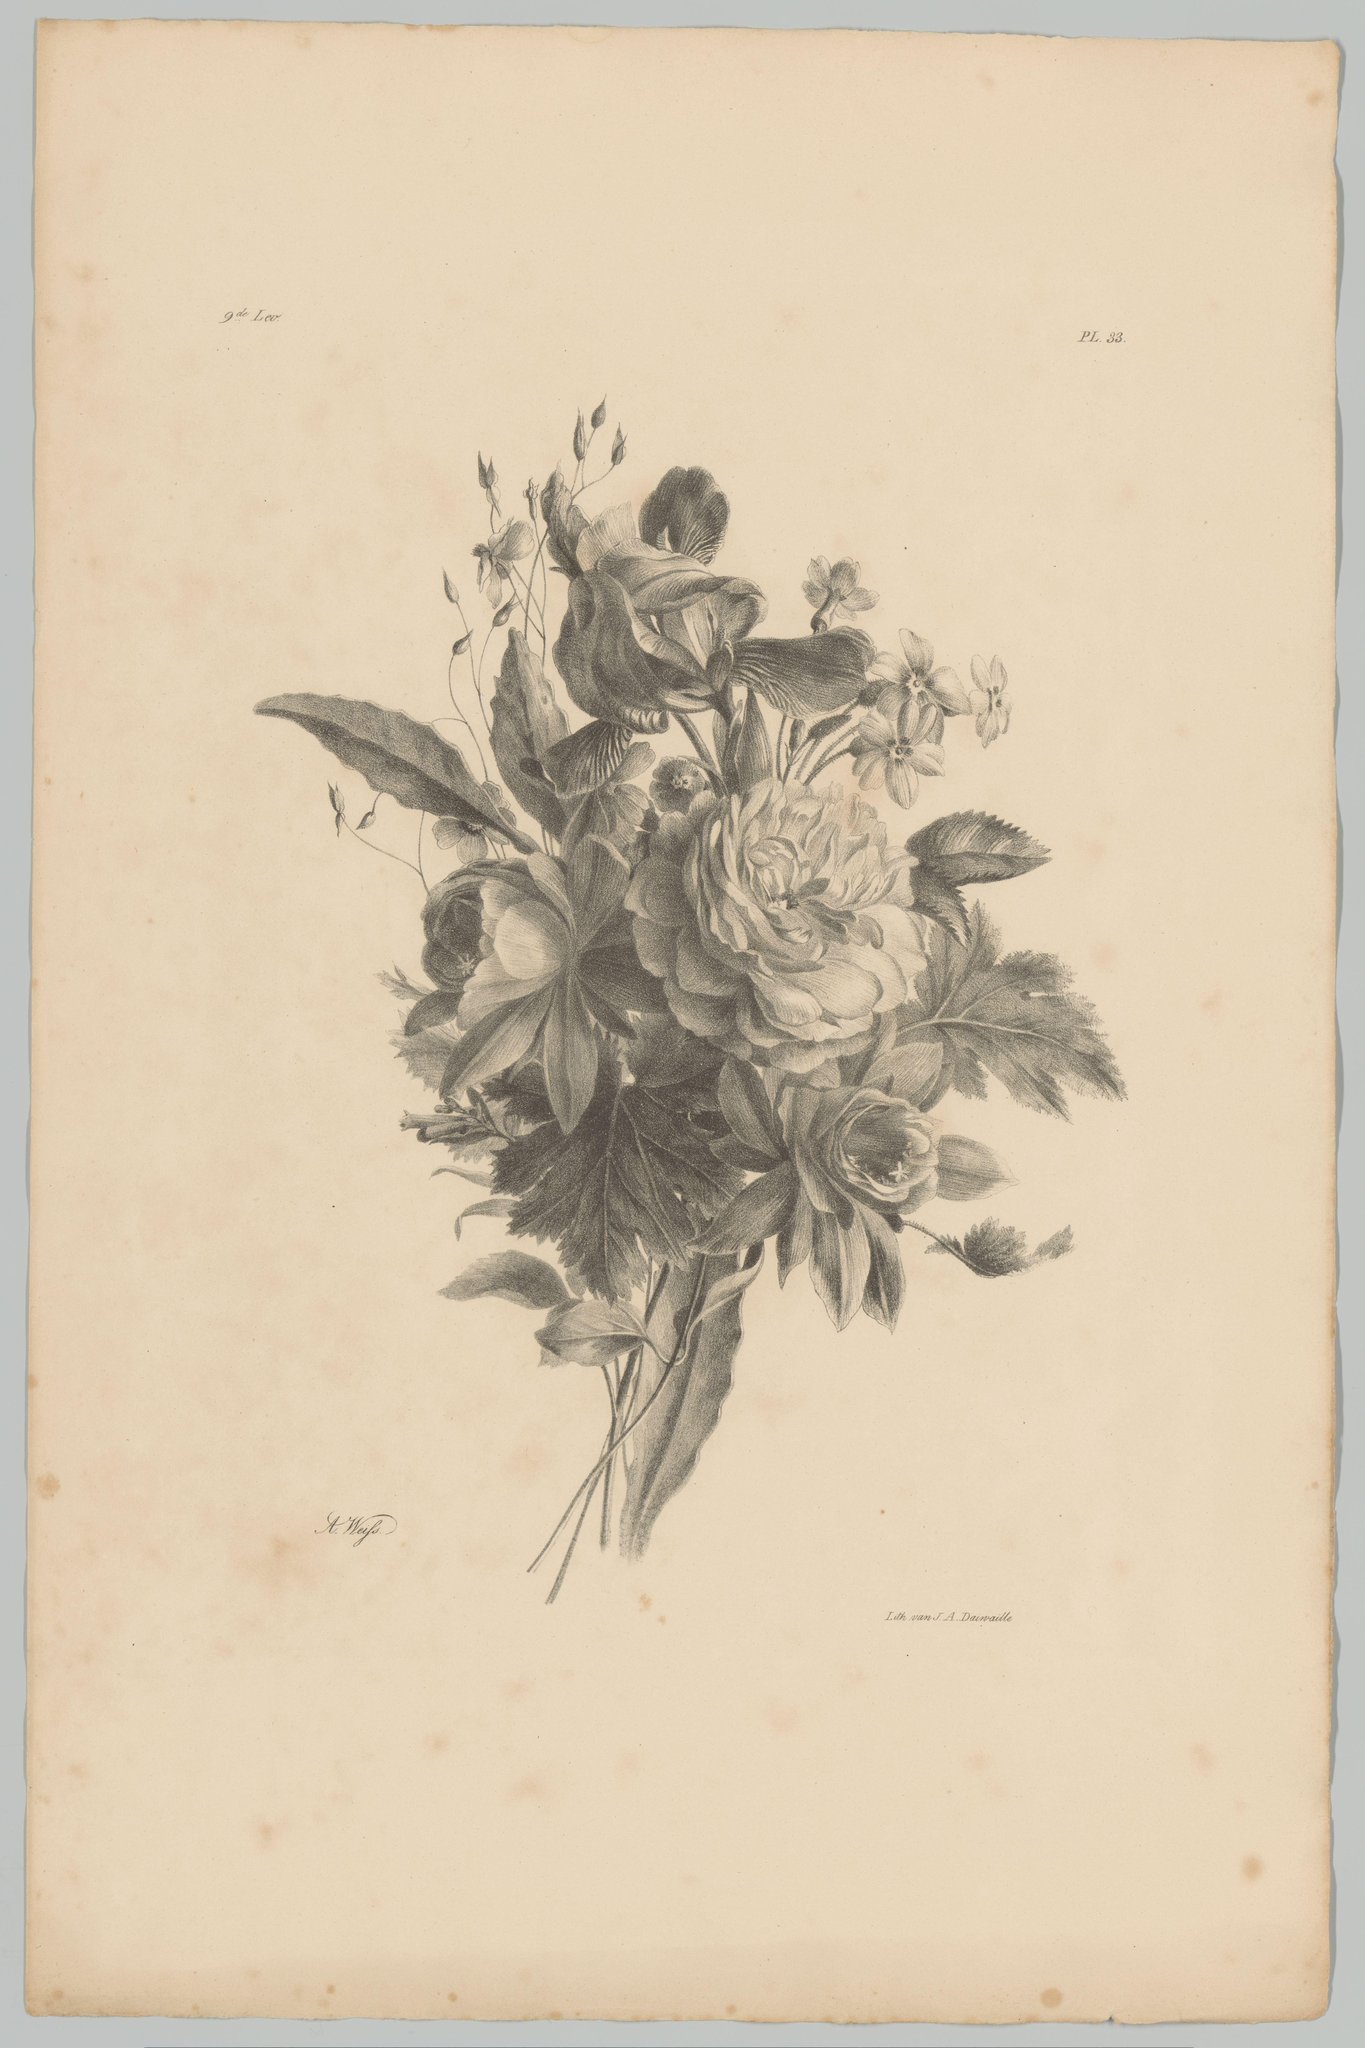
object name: print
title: Bloem en Fruit Studien (...) 3de aflevering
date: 1820-1833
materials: paper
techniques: lithograph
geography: amsterdam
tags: flowers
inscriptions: collector's mark: Lugt 2228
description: Links boven genummerd 9de Lev. Onderdeel van een omslag met in totaal zevenenzeventig lithografieën van bloemen en fruit.